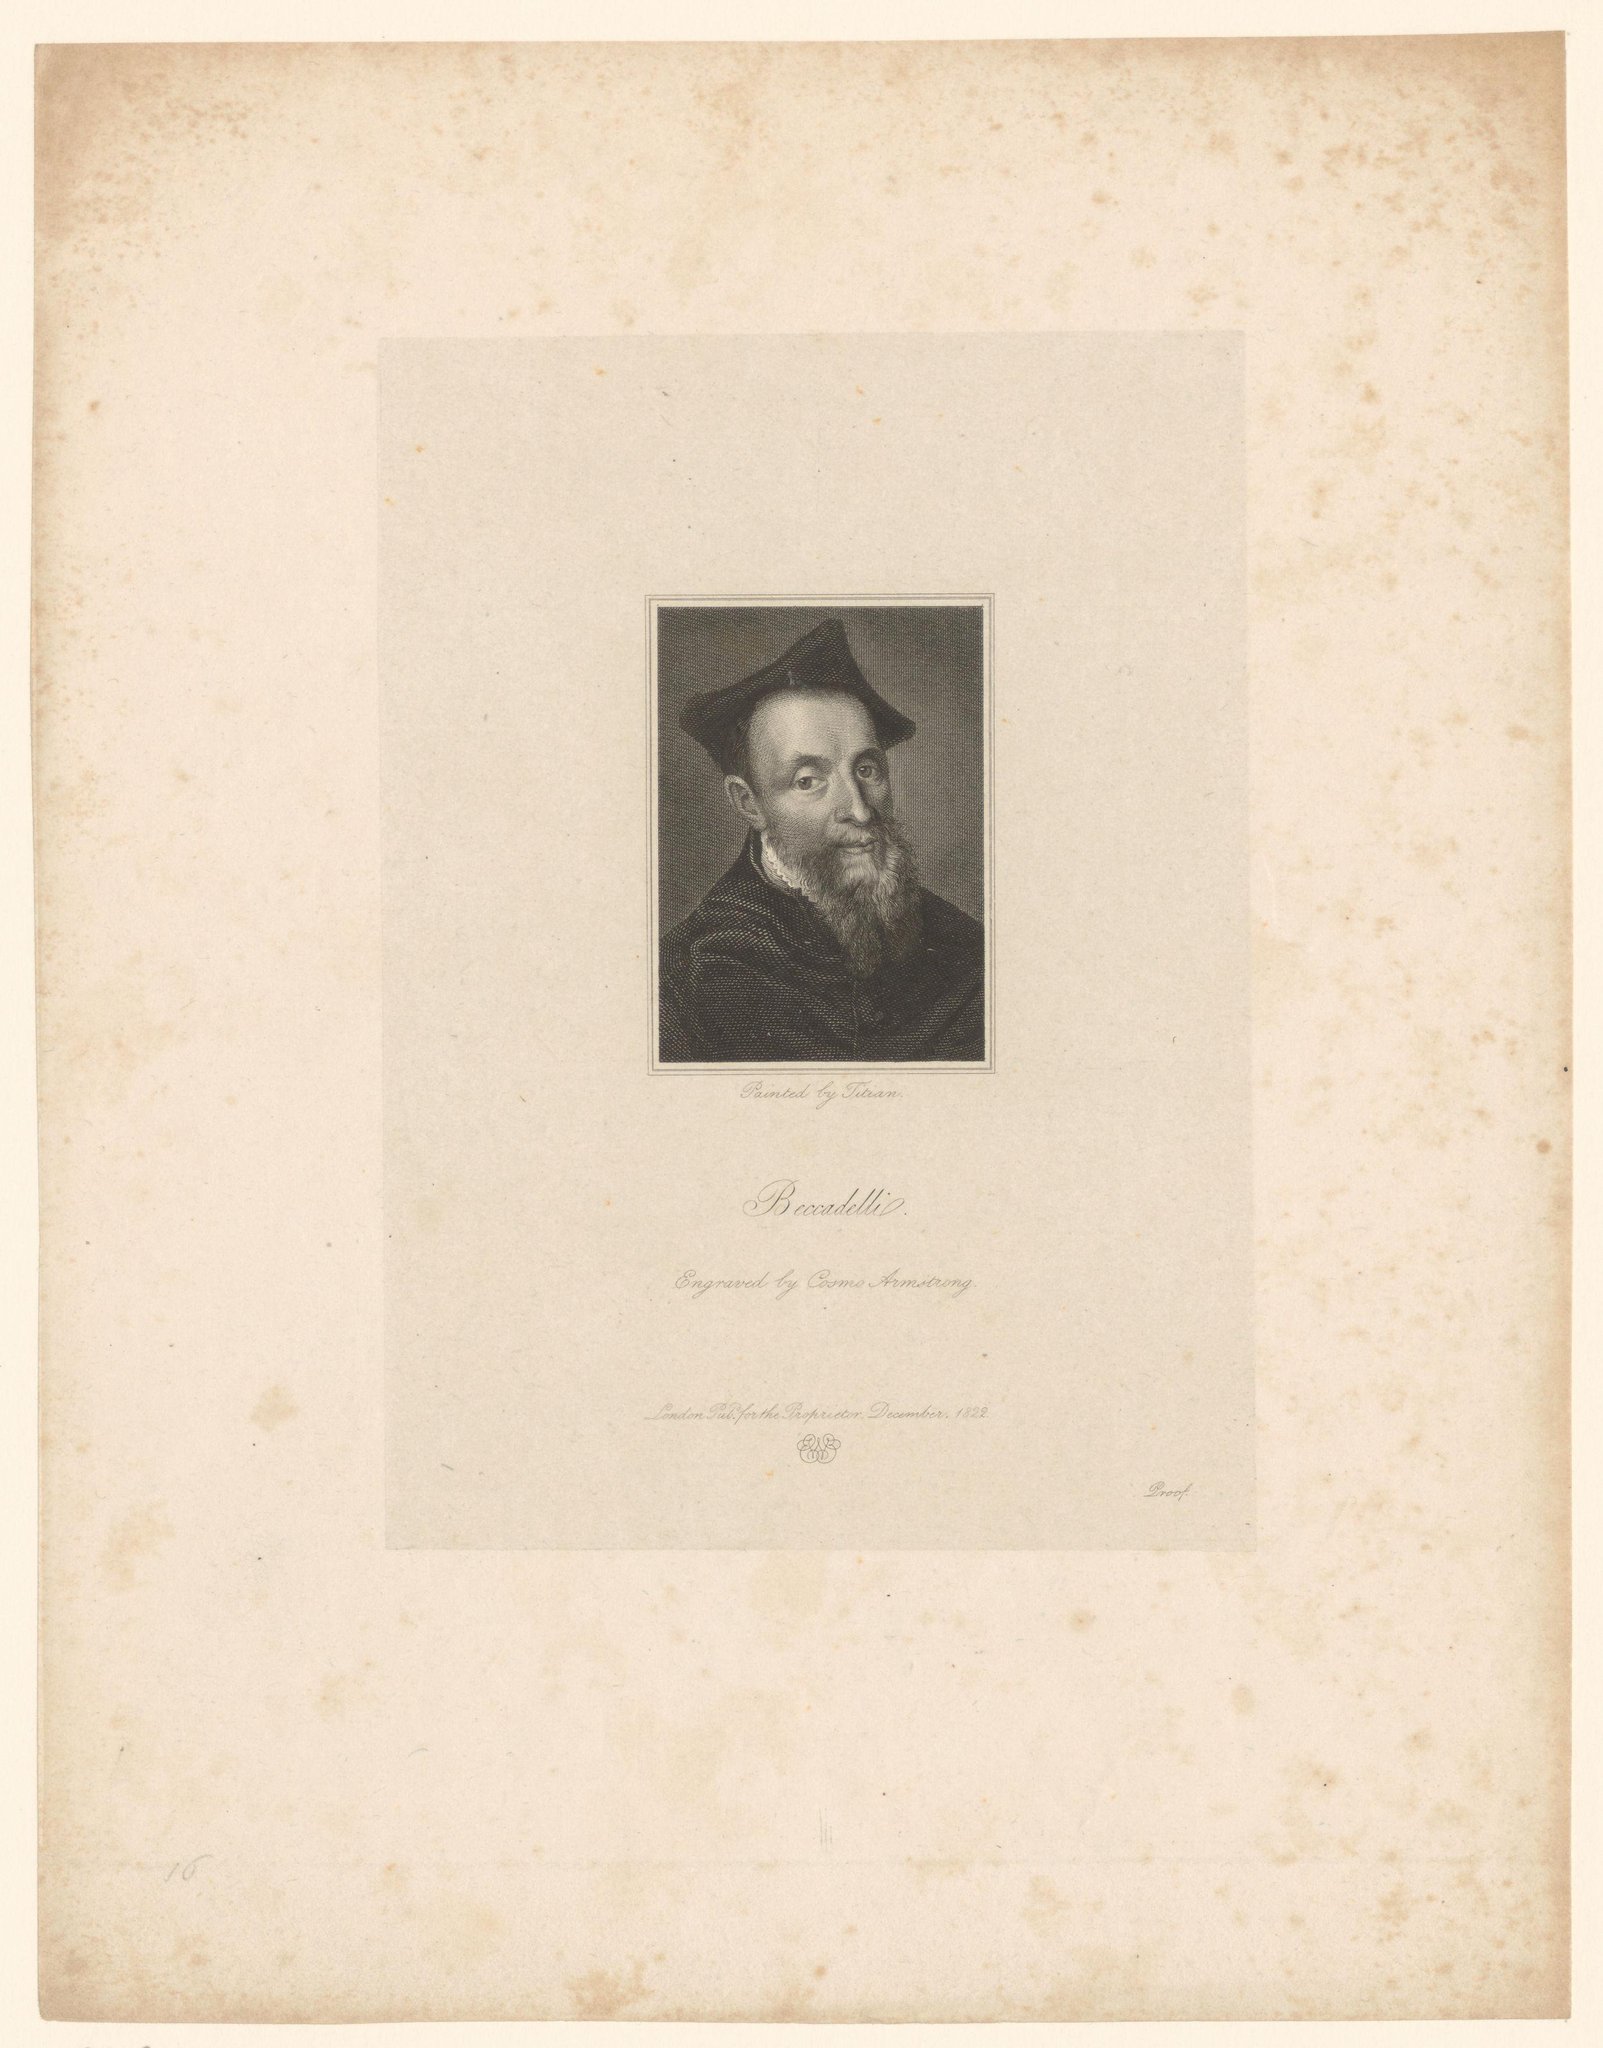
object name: print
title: Portret van Ludovico Beccadelli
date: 1812-1822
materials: paper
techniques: engraving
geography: england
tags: archbishop, bishop, etc. (roman catholic), historical persons (portraits and scenes from the life)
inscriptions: collector's mark: Lugt 2228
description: Prent ook gebruikt in: Walmsley, Edward. Physiognomical Portraits: One Hundred Distinguished Characters from undoubted originals (...). Londen: John Major et al., 1822, dl. 1.